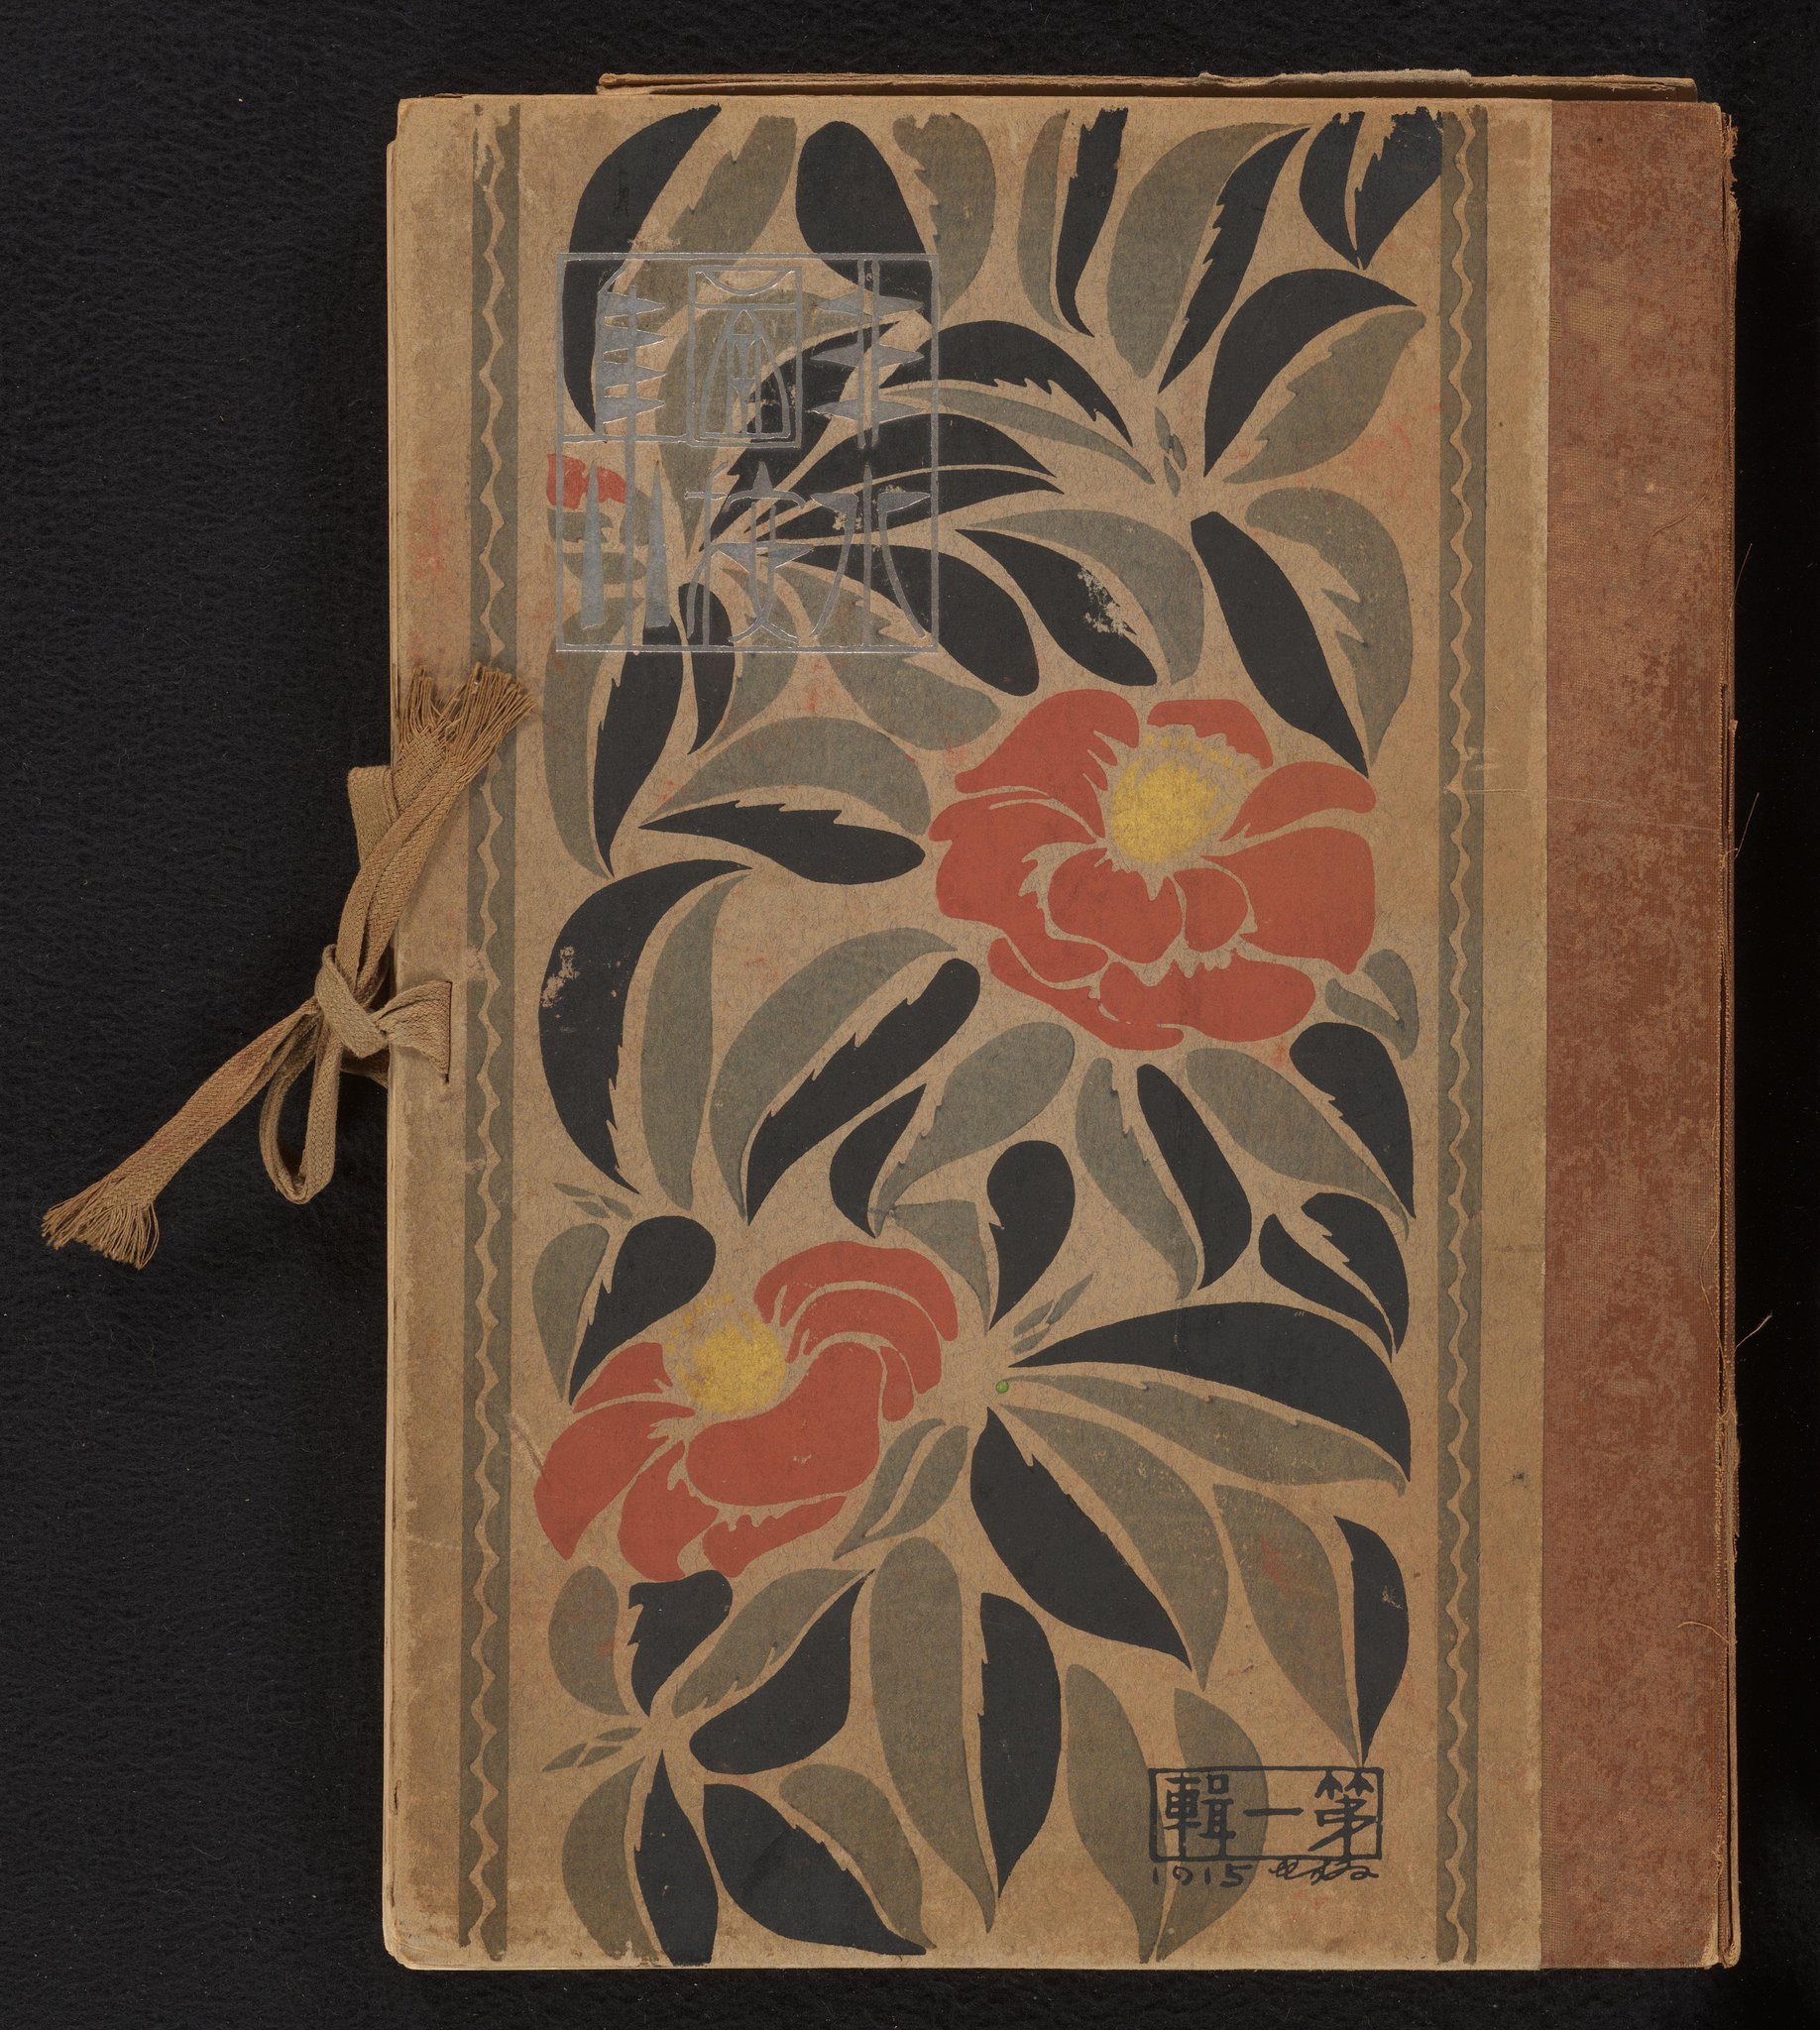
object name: book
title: Hisui zuanshu - dai isshu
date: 1905-1915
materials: paper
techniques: woodcut, letterpress printing, planographic printing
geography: tokyo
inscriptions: date